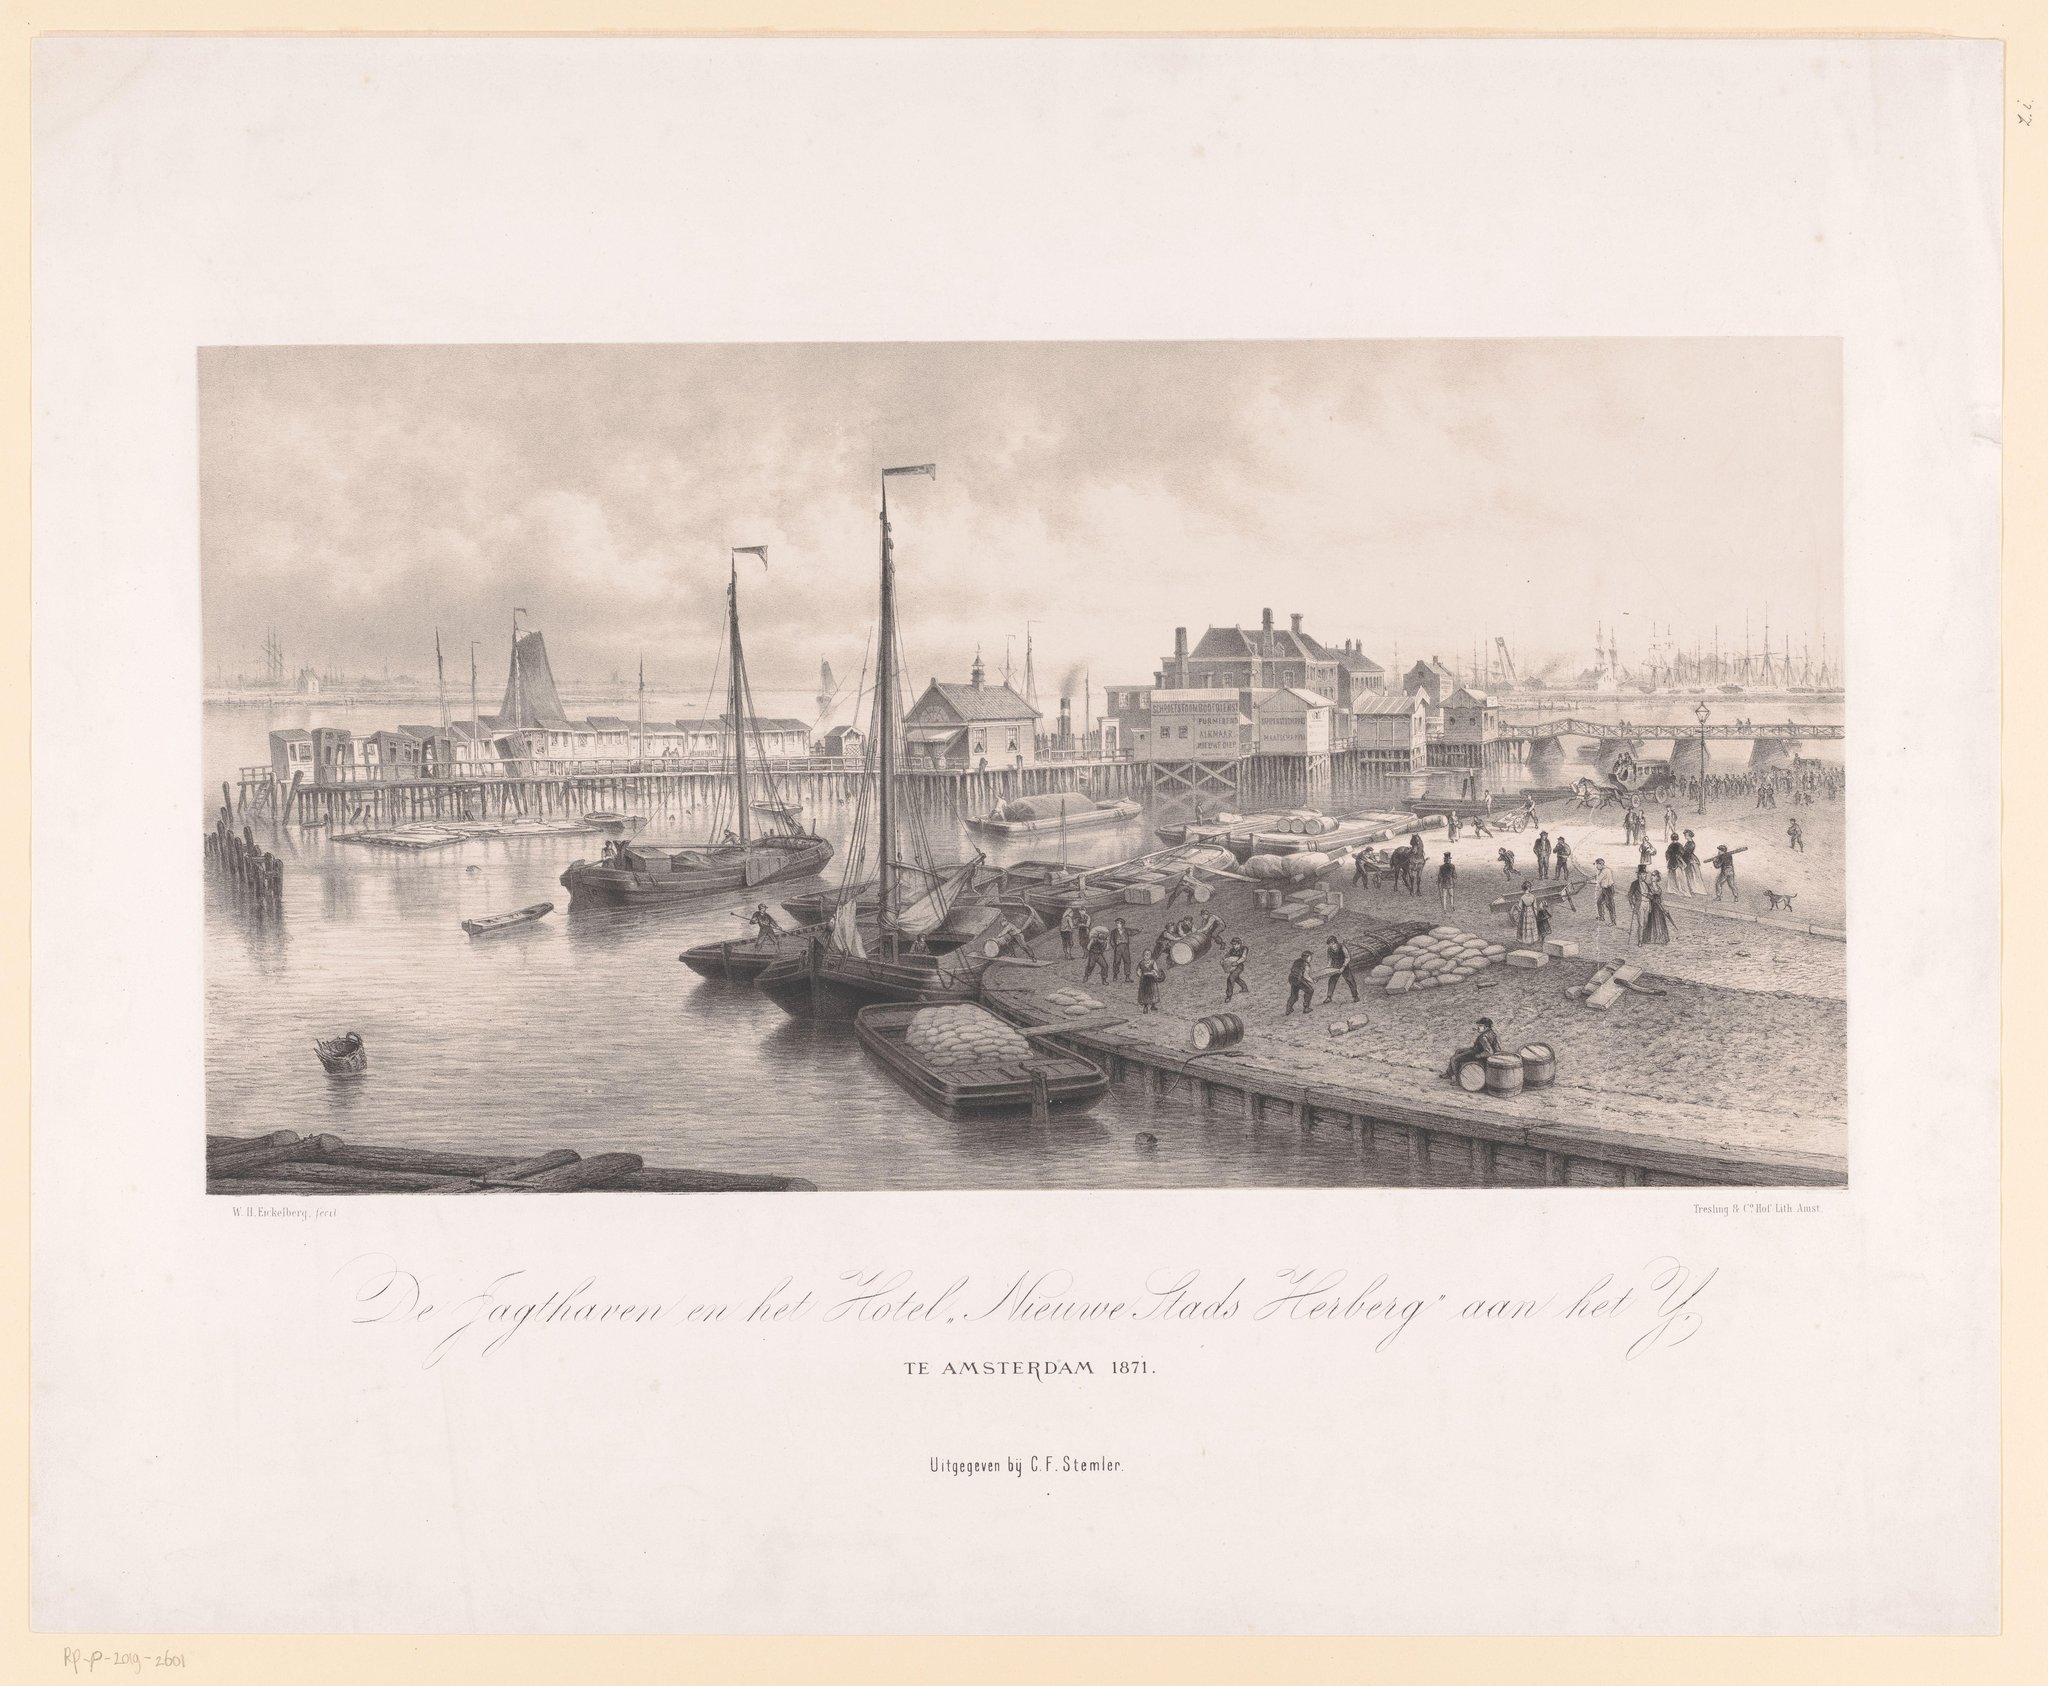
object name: print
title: Gezicht op de Nieuwe Stadsherberg te Amsterdam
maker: c.f. stemler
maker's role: publisher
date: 1871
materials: paper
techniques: tone lithography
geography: amsterdam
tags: ships (in general) - cc - more than one ship, pier, quay, wharf, hotel, hostelry, inn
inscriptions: date